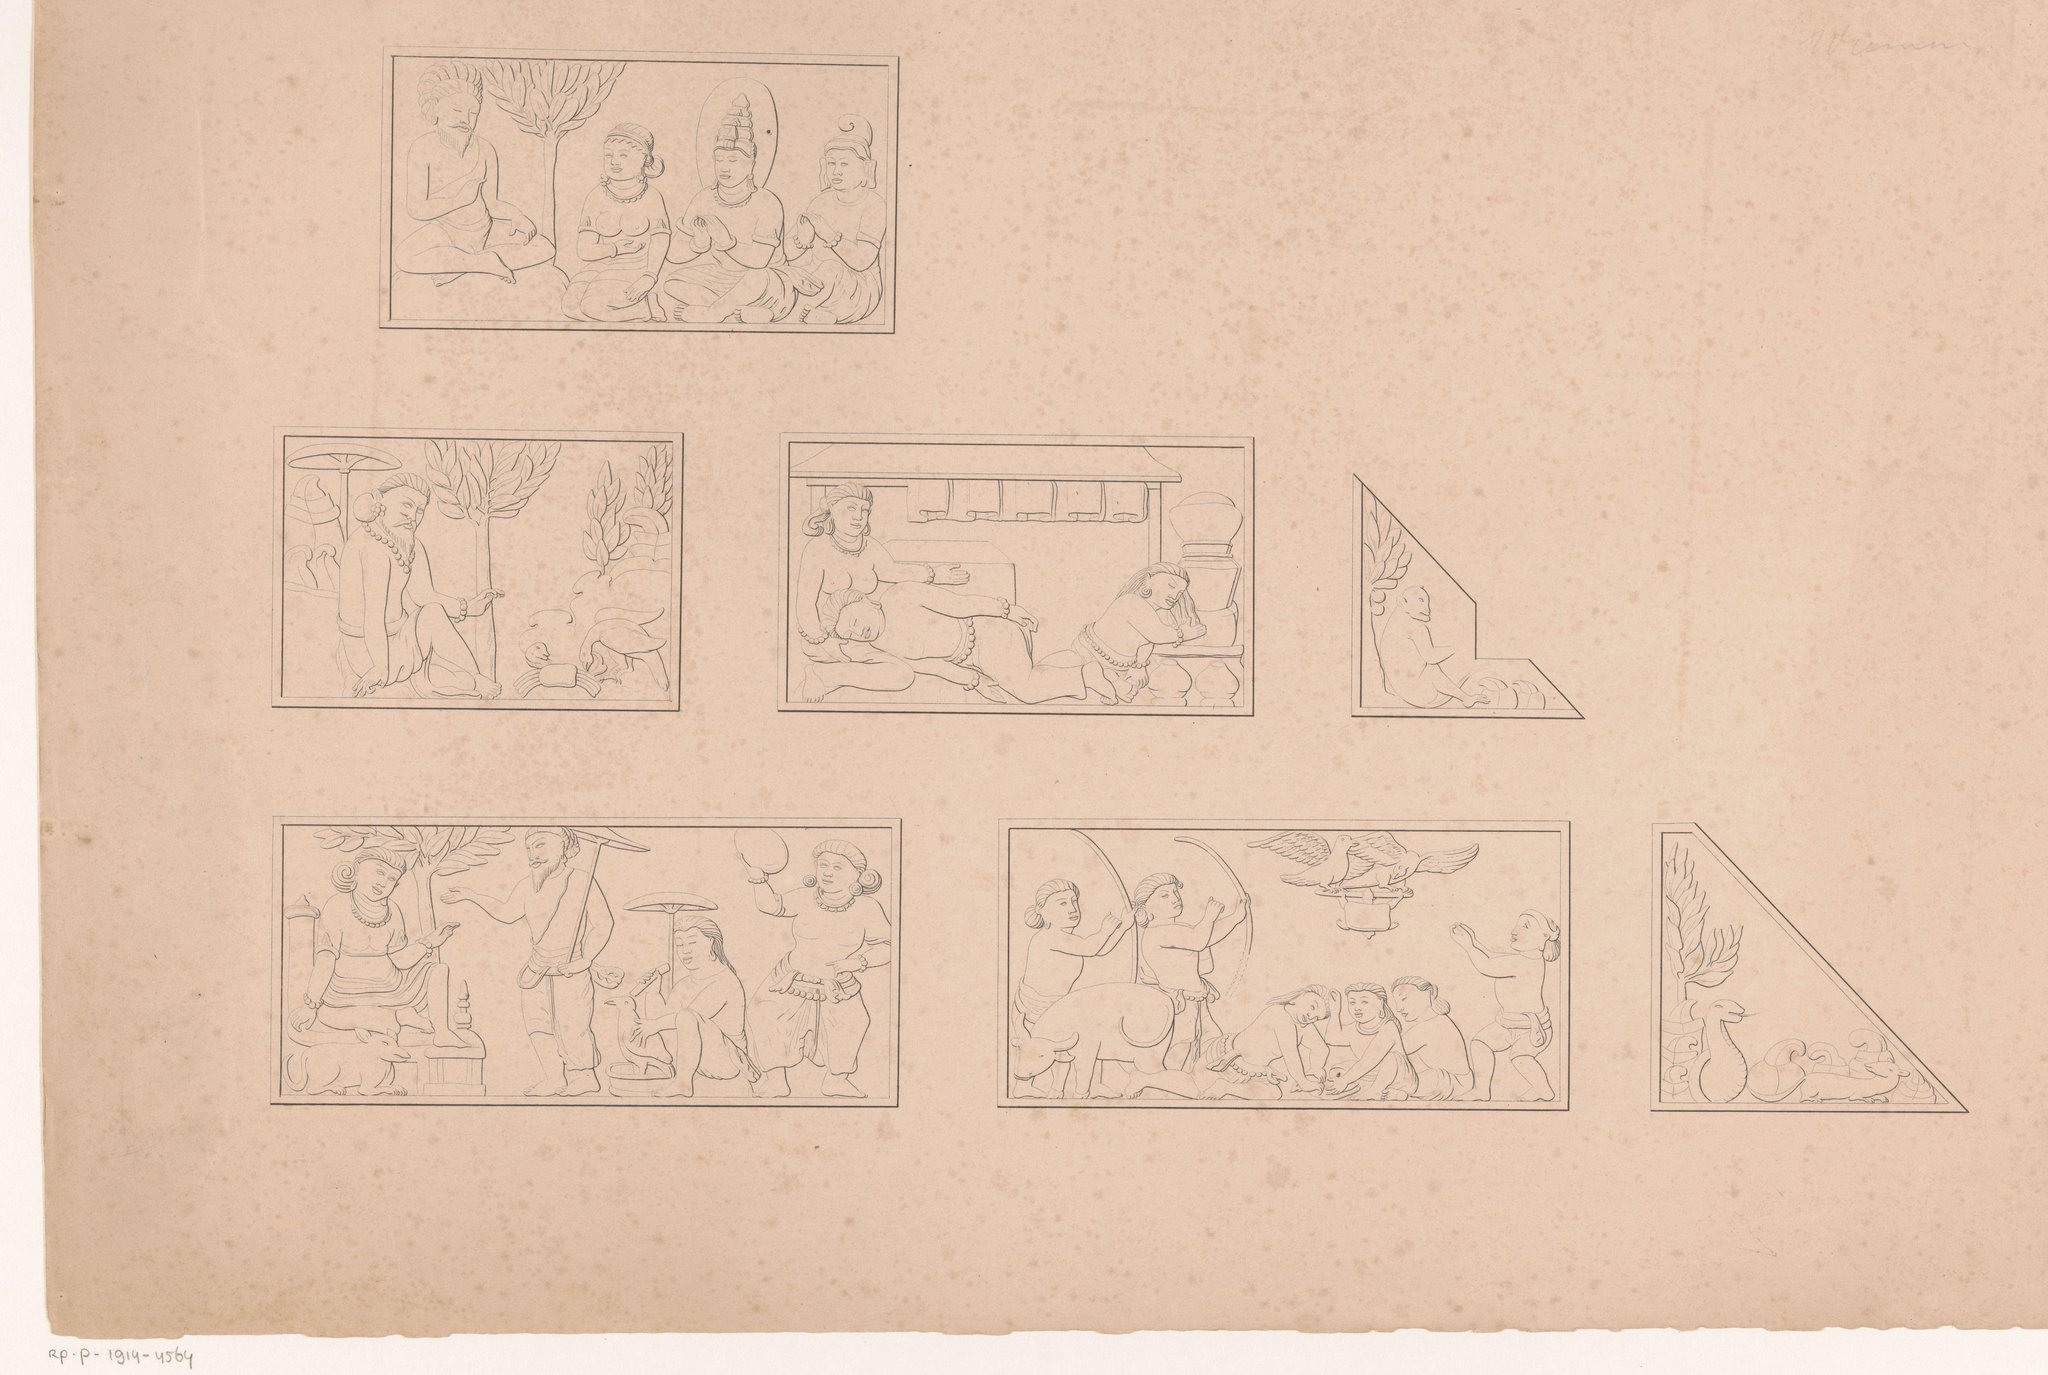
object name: print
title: Reliëf aan de rechterzijde van de grote trap bij de tempel Candi Mendut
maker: andries wiemans cz.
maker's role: print maker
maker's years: 1826-1858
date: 1836-1858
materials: paper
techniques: lithograph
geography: dutch east indies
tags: statues, paintings, etc. ~ objects of worship (hinduism, buddhism, jainism)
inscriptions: collector's mark: Lugt 2228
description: Afgebeeld zijn zeven scènes zoals ze ook op de trap zijn gepositioneerd.